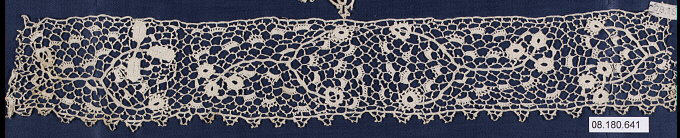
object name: border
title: Borders (2)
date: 1834-1866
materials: linen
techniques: crochet